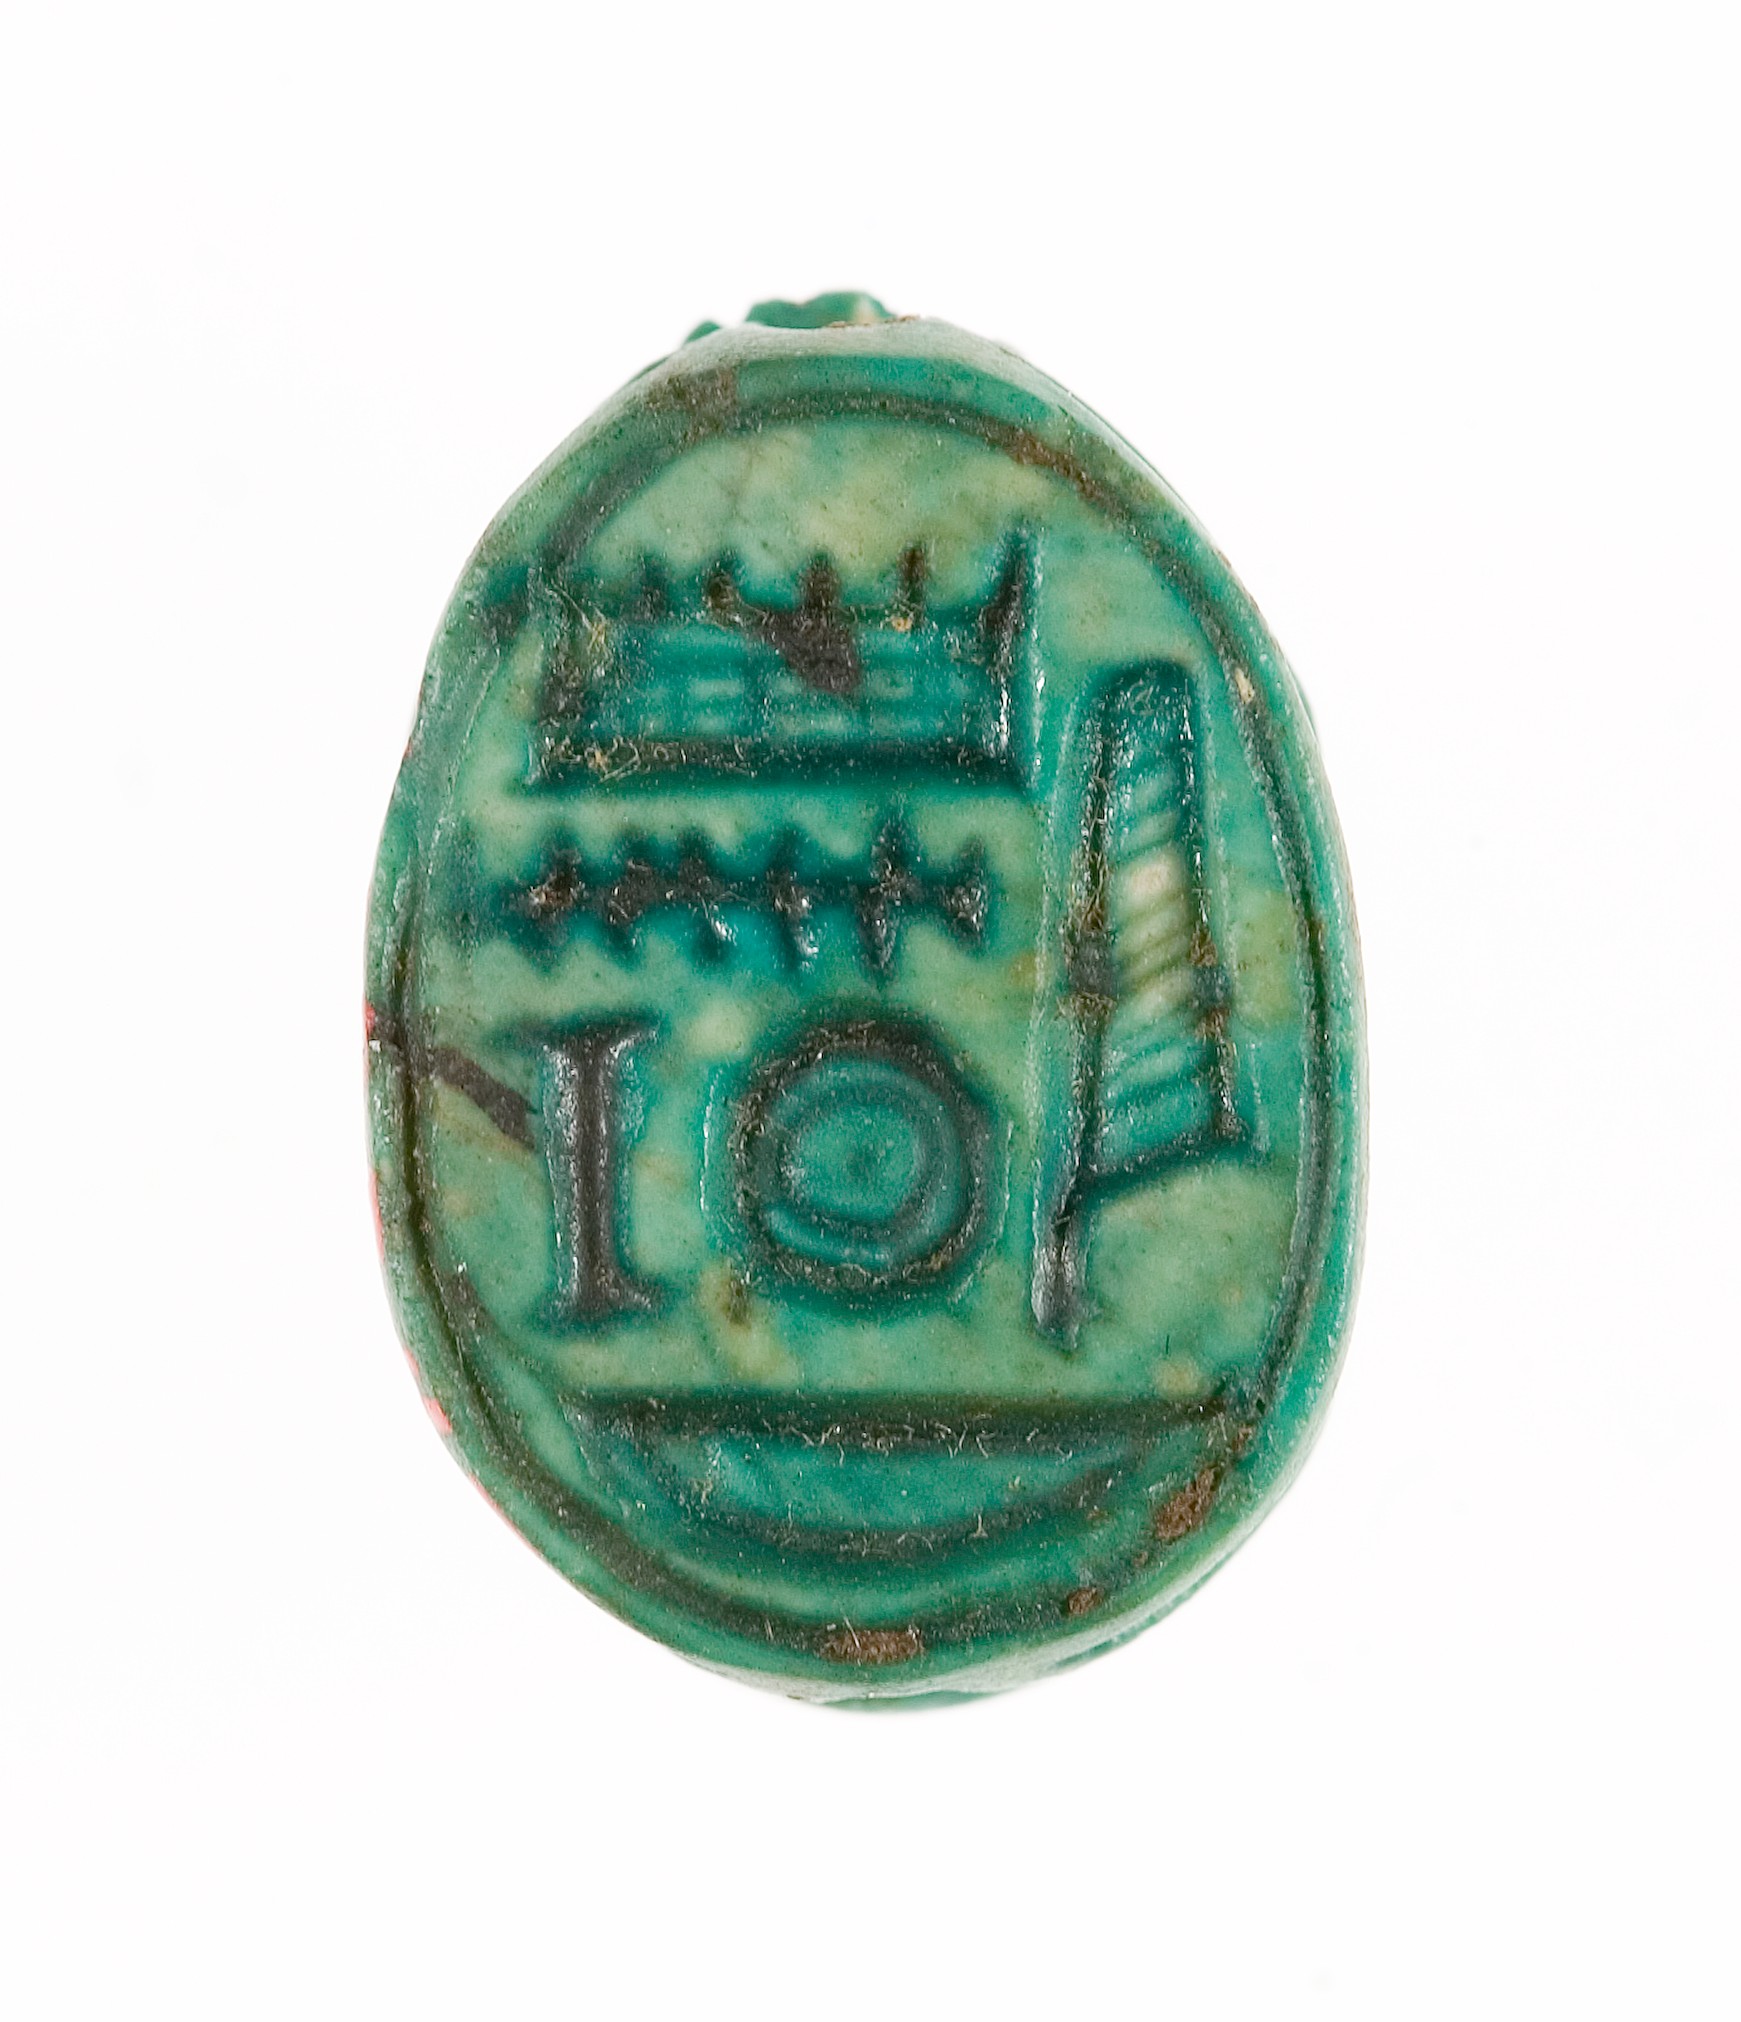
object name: scarab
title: Scarab Inscribed with the Name of the God Amun-Re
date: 1479-1458 BCE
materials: stone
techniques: glazing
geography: egypt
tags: amun,scarabs